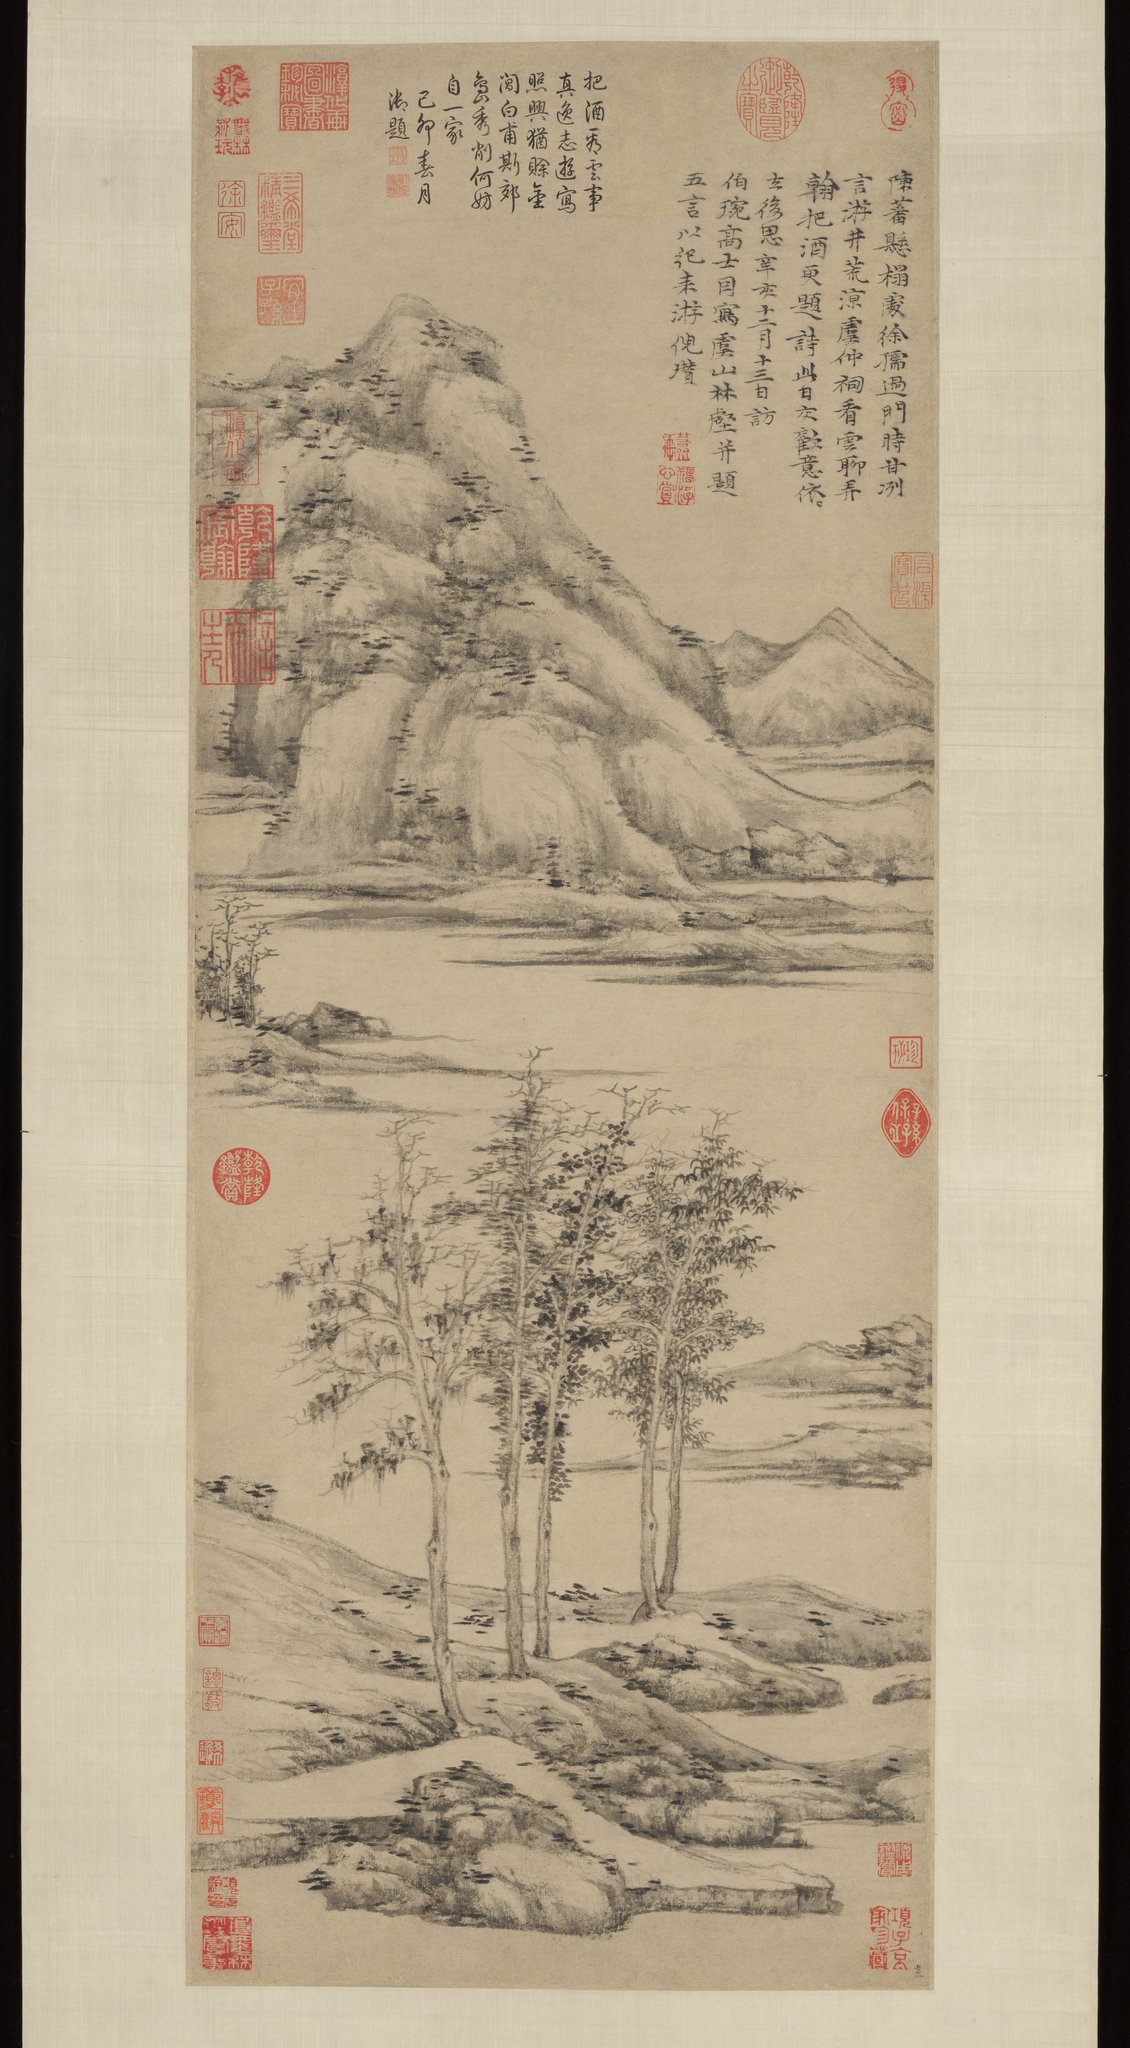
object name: hanging scroll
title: Woods and Valleys of Mount Yu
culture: chinese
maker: ni zan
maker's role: artist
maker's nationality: chinese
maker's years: 1306-1374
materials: ink, paper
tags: mountains,landscapes